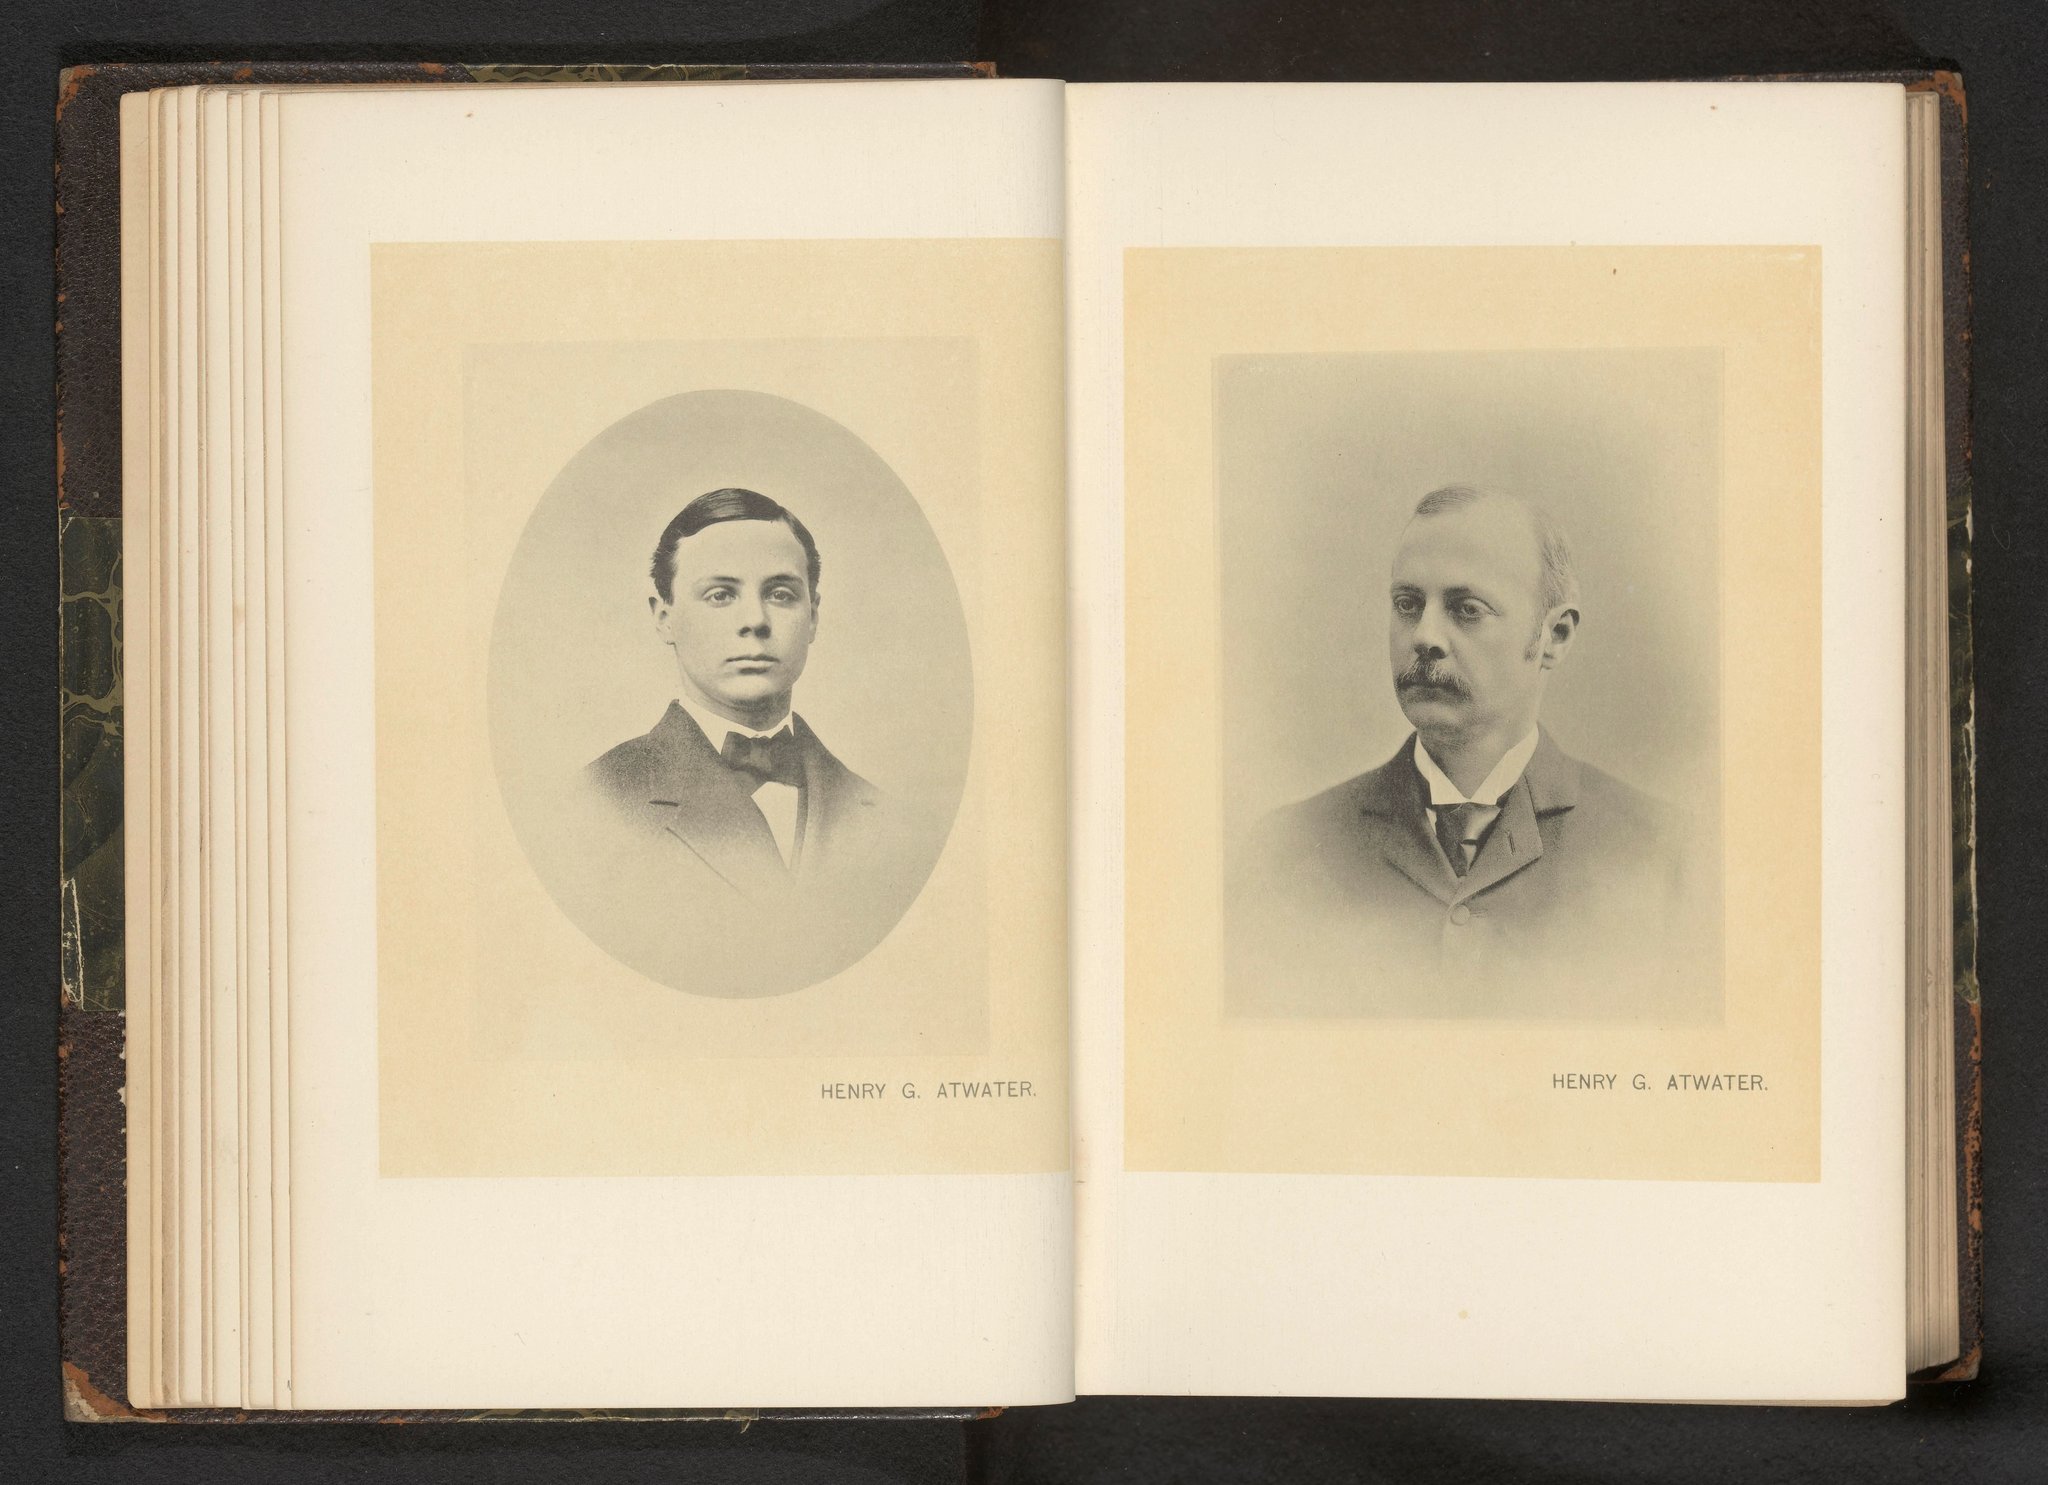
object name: page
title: Henry G. Atwater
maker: Anonymous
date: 1889-1894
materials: paper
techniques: photoaquatint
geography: boston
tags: adult man